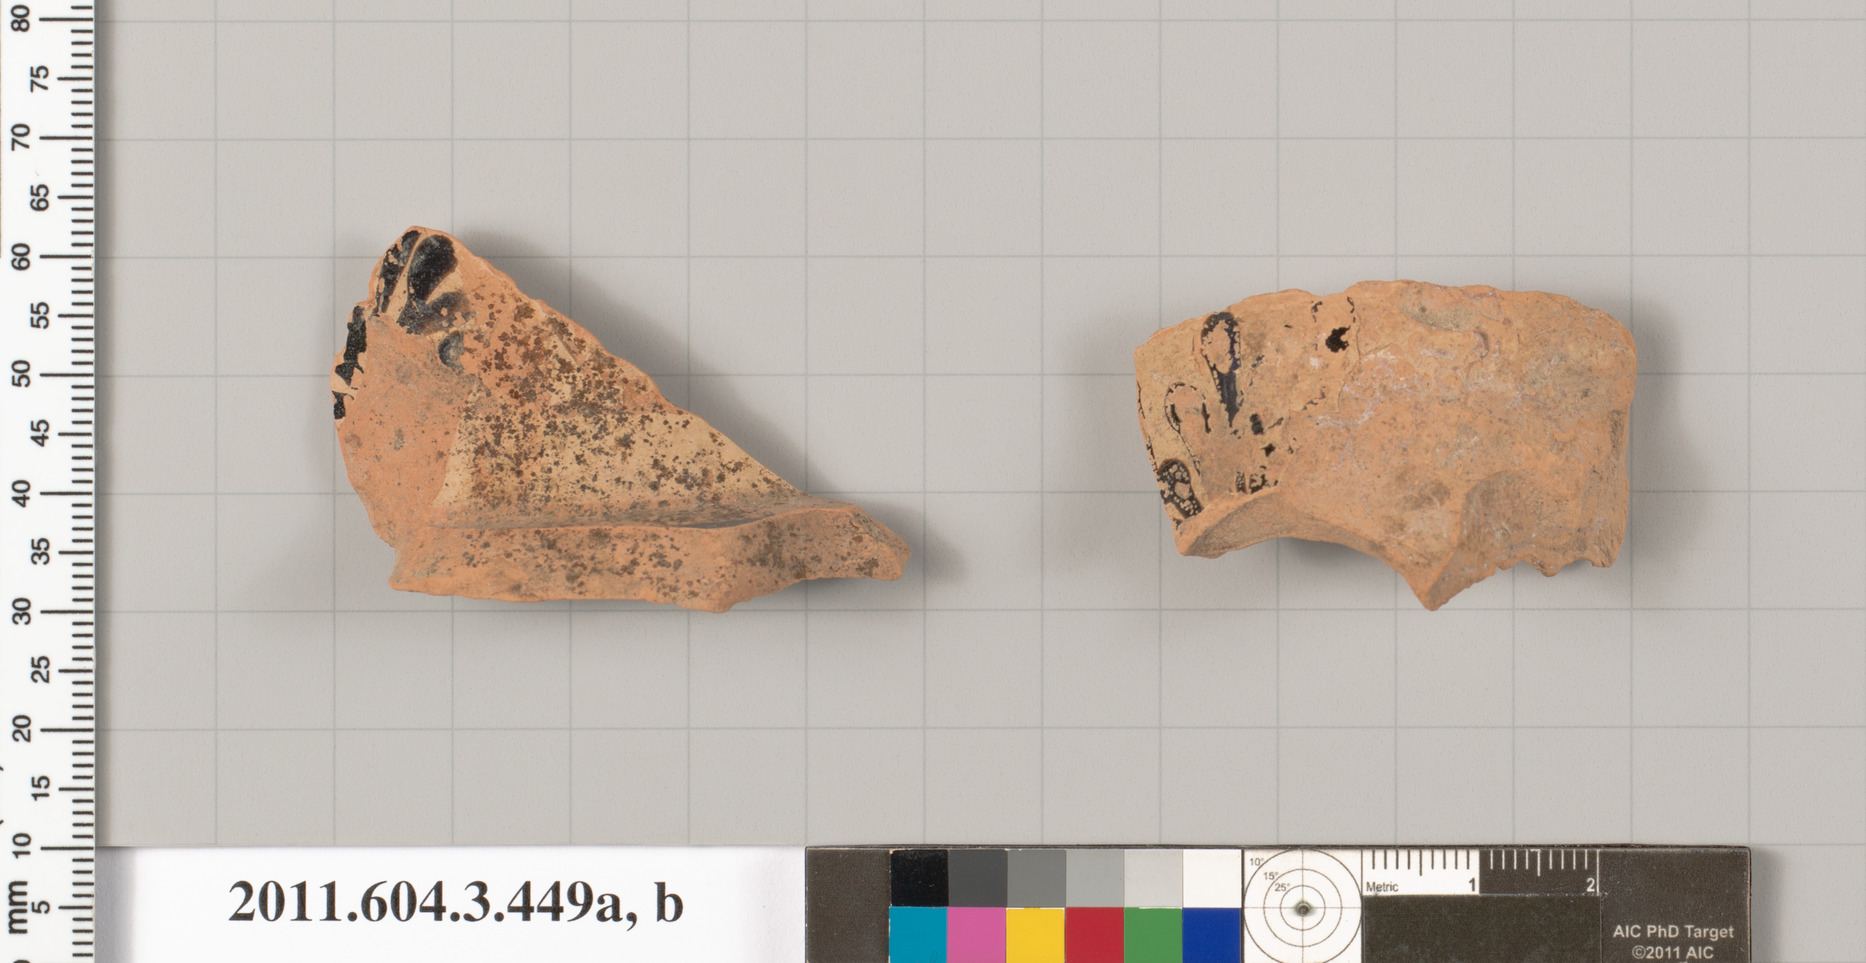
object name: neck amphora fragment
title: Terracotta fragments of a neck-amphora (jar)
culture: greek, attic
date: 490-480 BCE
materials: terracotta